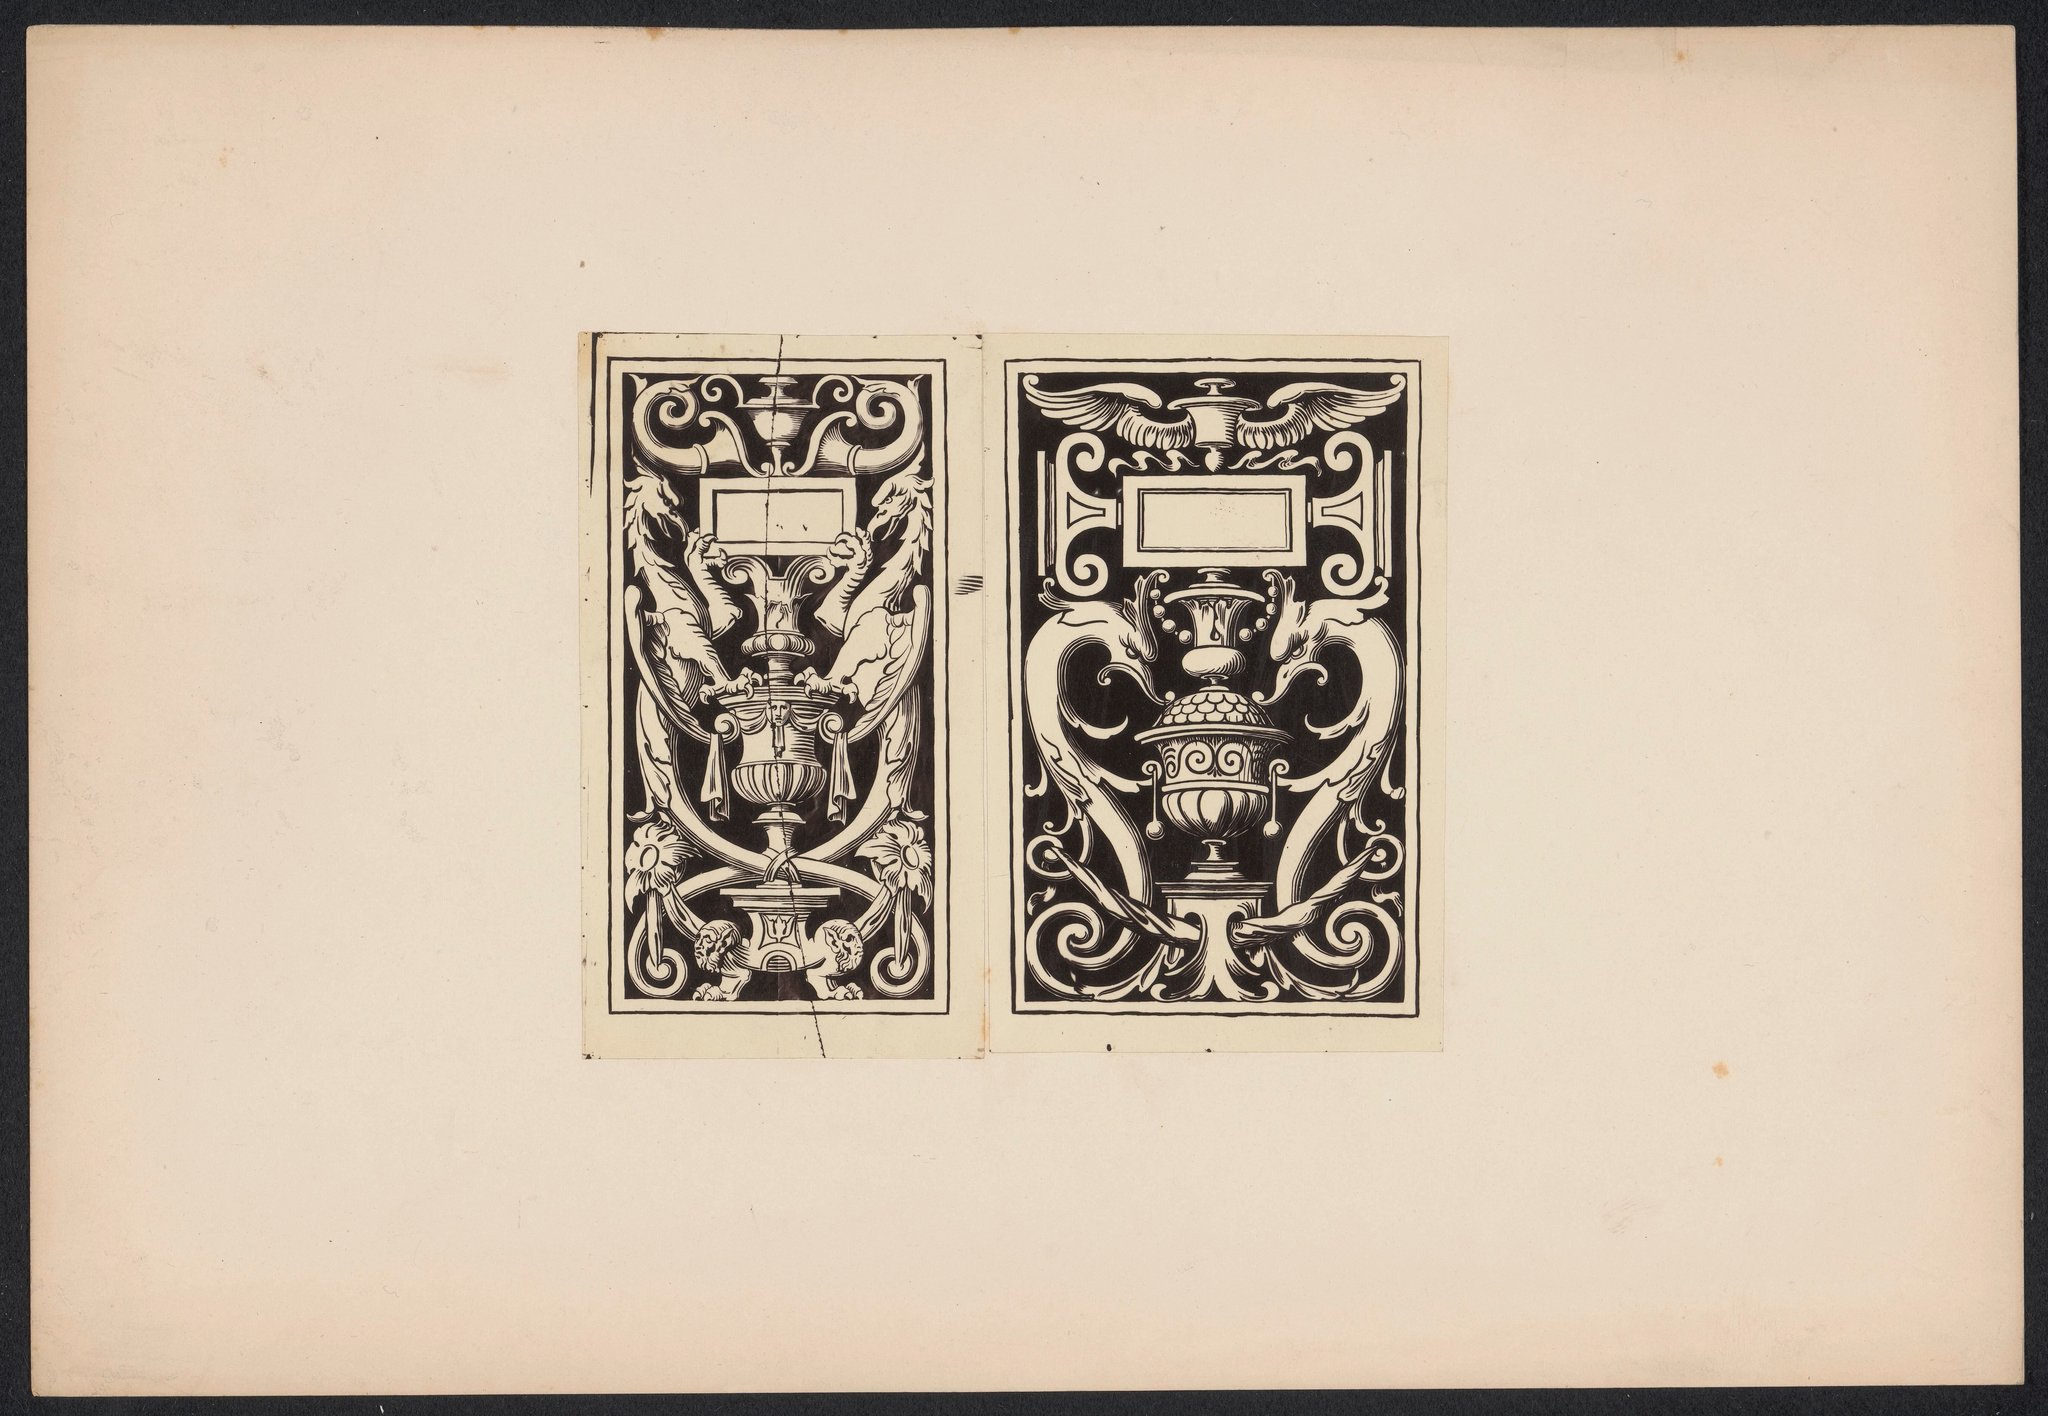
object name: photomontage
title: Overzicht van twee ornamentprenten met draken en fantasiewezens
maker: Anonymous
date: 1875-1900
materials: cardboard, photographic support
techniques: albumen print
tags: ornament ~ hybrid animals, other fantasy ornament, vase ~ ornament, dragon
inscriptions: collector's mark: Lugt 3937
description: Links een ornamentprent met draken, rechts een ornamentprent met fantasiewezens.